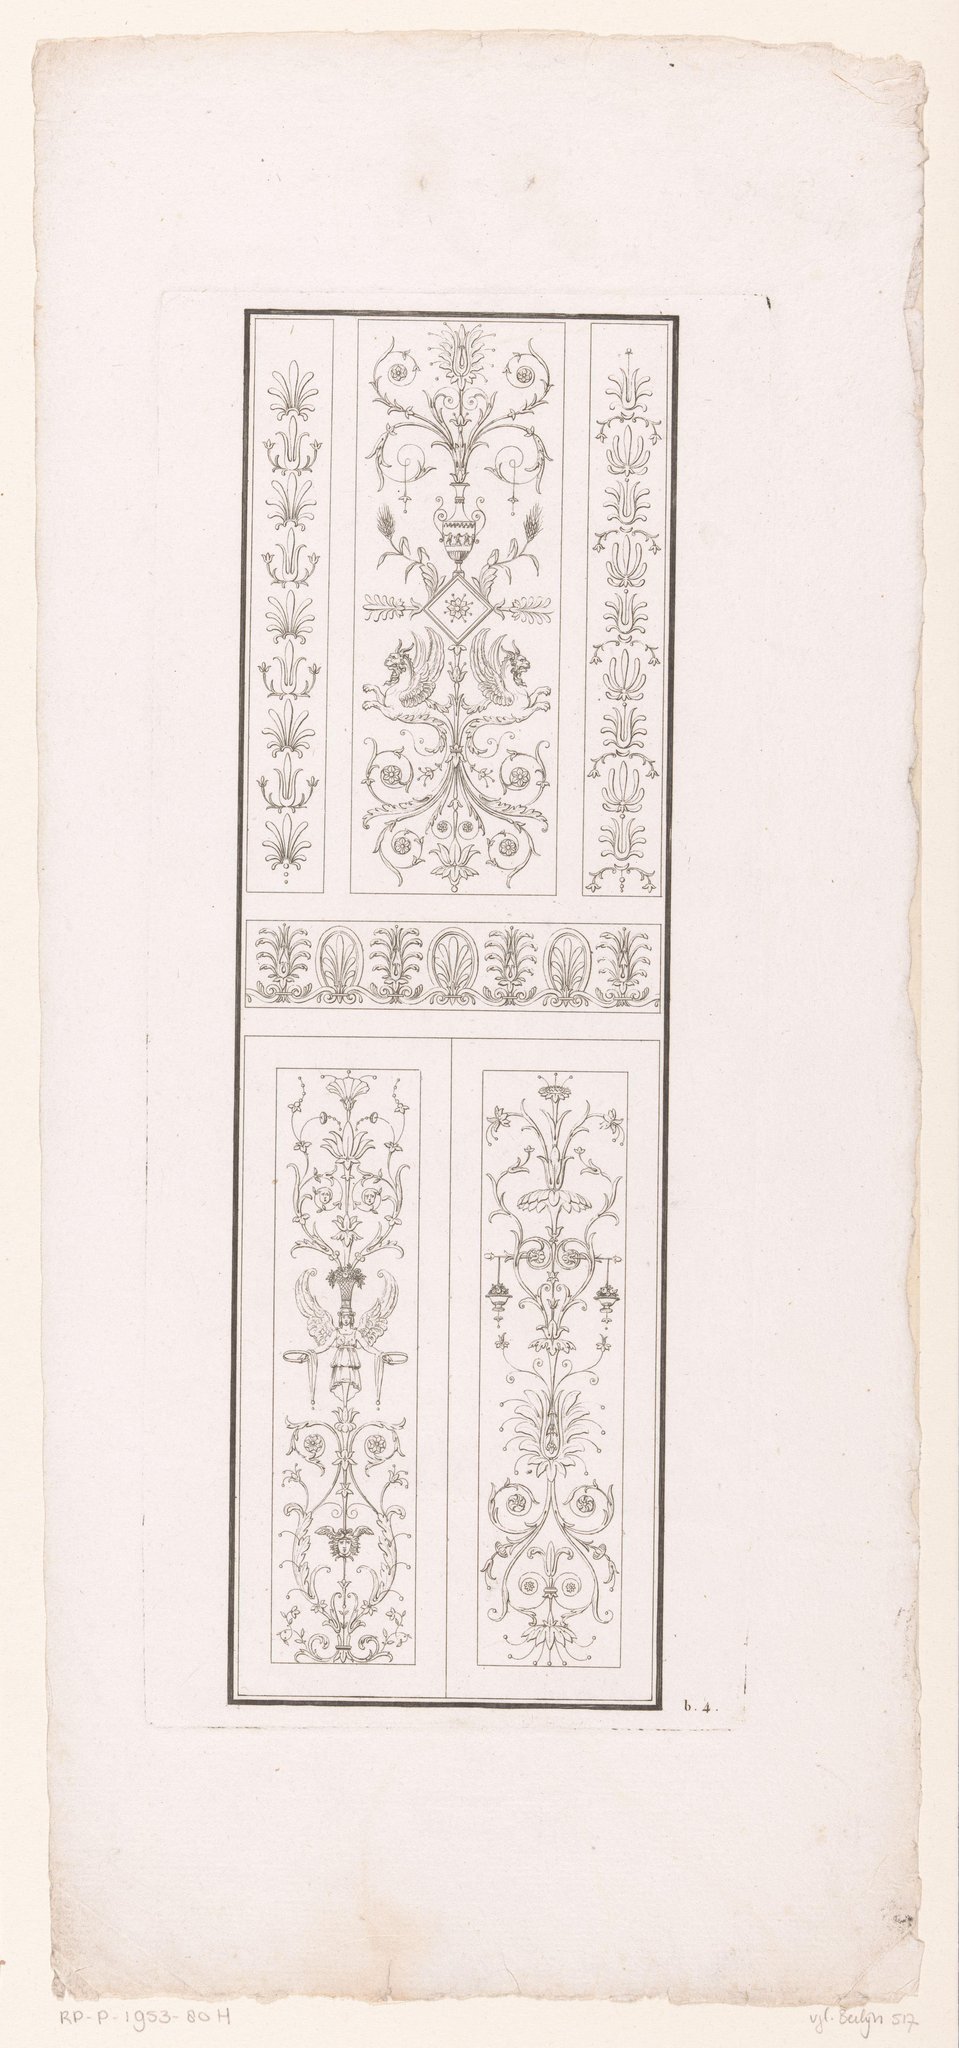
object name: print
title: Drie panelen met arabesken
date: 1803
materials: paper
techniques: engraving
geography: paris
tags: ornament ~ arabesque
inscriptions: collector's mark: Lugt 2228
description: Drie panelen en drie banden met arabesken. Midden boven met aren en griffioenen. Links onder met een engel met bloemenmand en kransen. Rechts onder met bloemen.